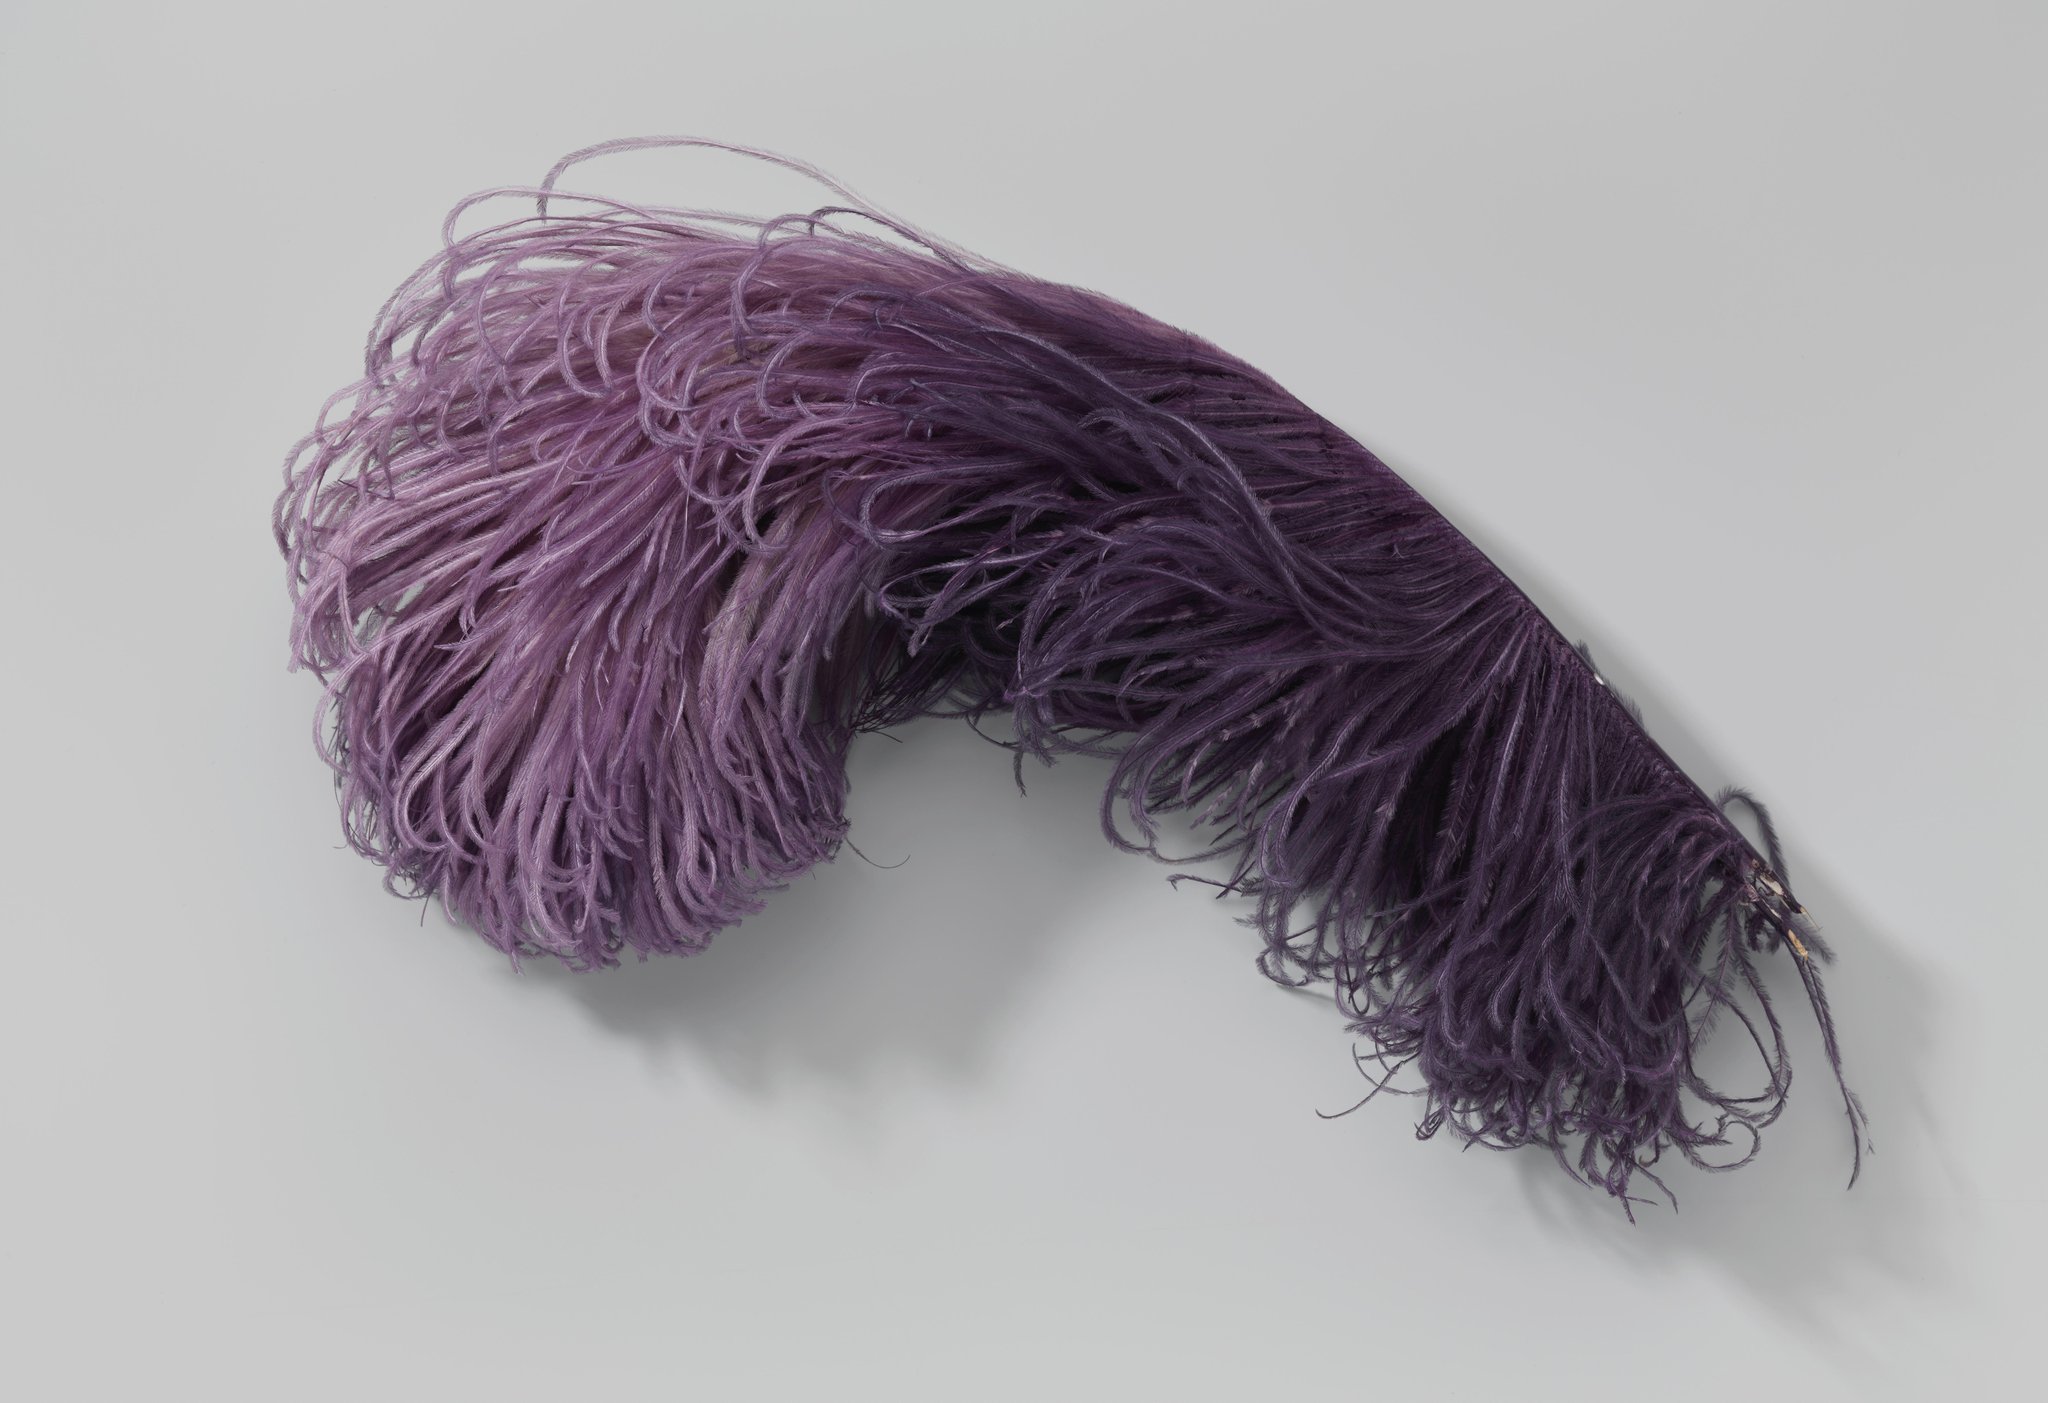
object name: womenswear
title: Toef struisveren in fletspaars tot lila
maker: Anonymous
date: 1895-1915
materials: ostrich feather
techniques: painting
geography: western europe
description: Een korte struisveer in fletspaars tot lila.